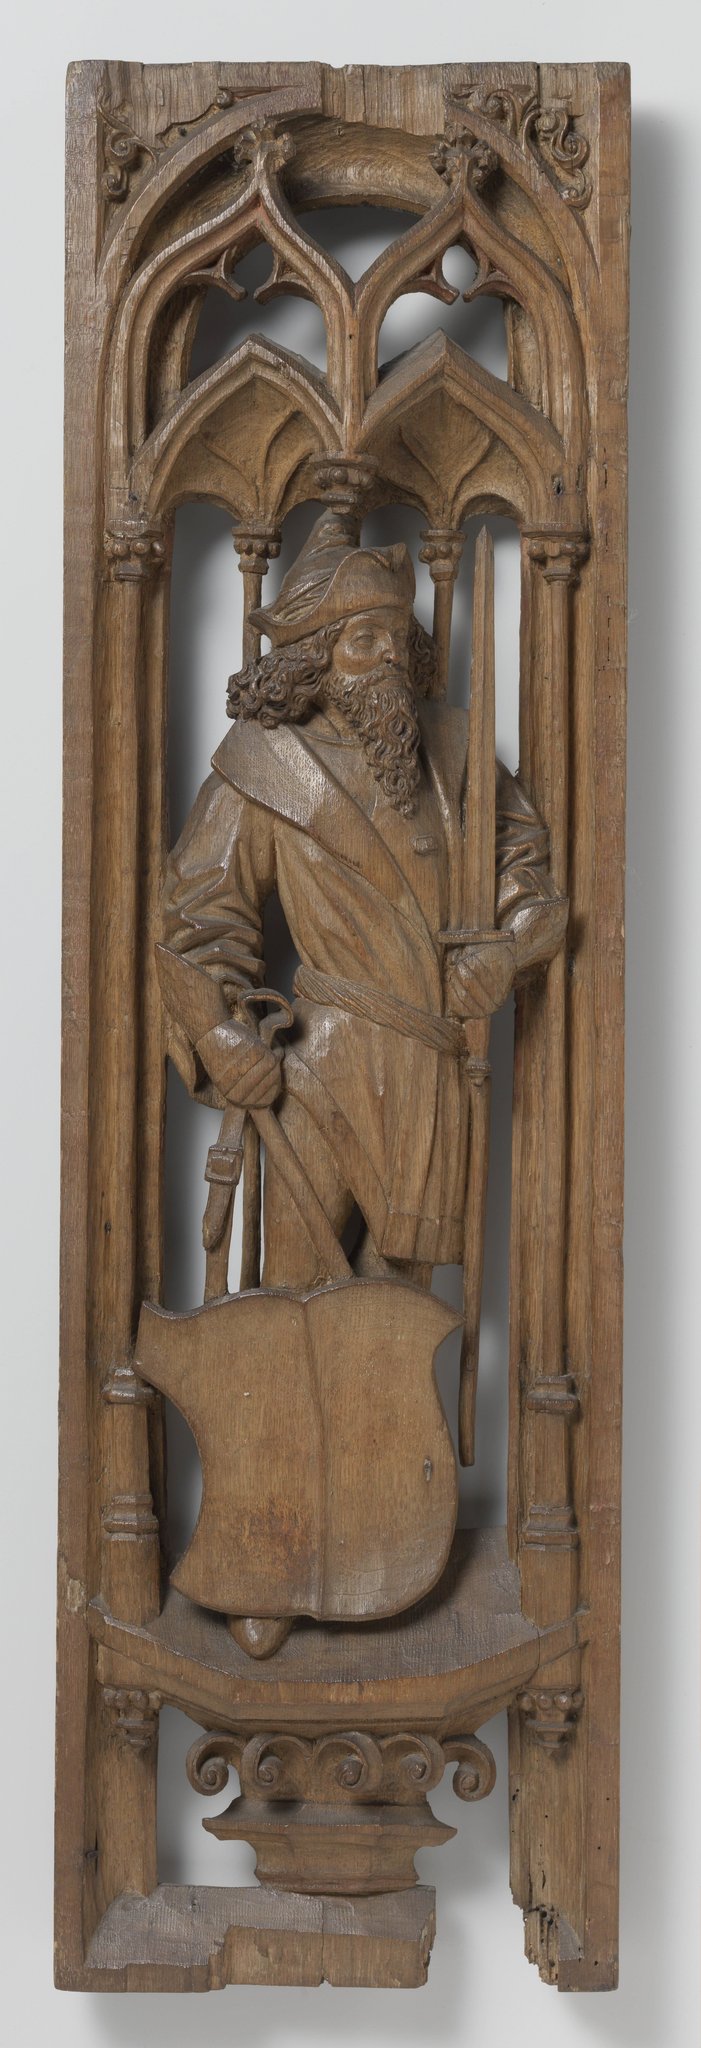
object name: orgelkast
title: Panel with a Knight Supporting an Escutcheon, from the Organ of the Sint-Vituskerk, Naarden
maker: jan eerstensz van schayck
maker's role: sculptor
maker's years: 1470-1527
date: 1510-1520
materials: wood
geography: utrecht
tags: knight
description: These ten figures adorned the medieval organ in the church of Saint Vitus in Naarden. Each figure holds a weapon and a coat of arms on a strap. Some are dressed as knights with a breastplate and a helmet, others as princes or noblemen. They may represent the Counts of Holland. All the shields would have originally been painted.